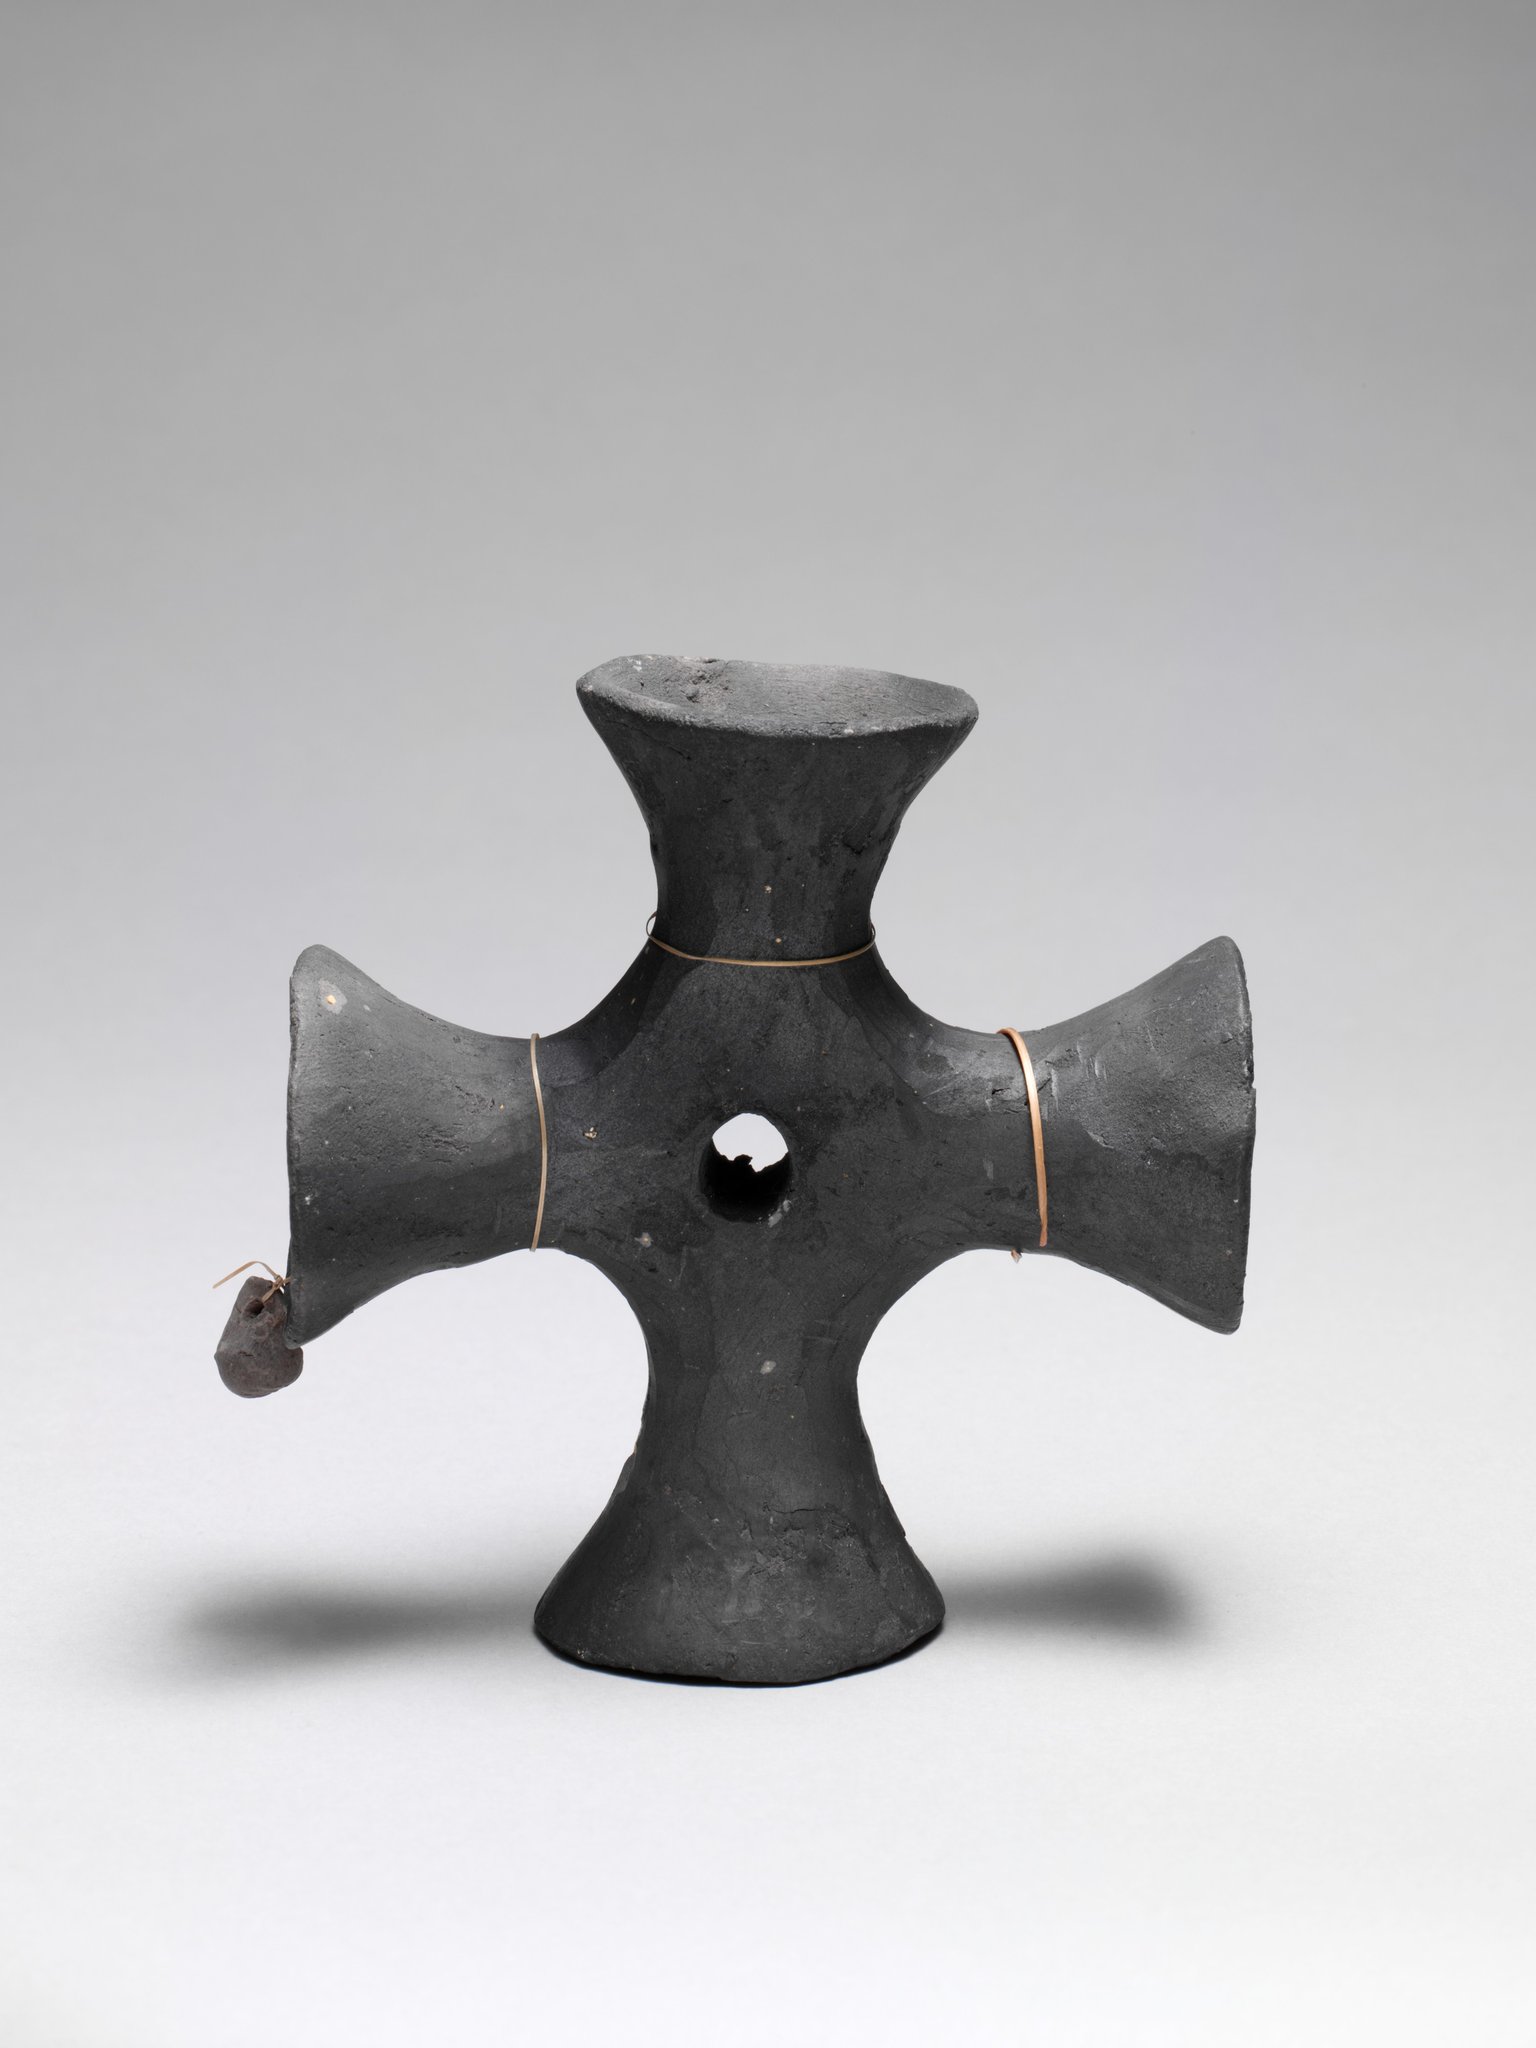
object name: bell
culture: mexican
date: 1889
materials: clay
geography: mexico